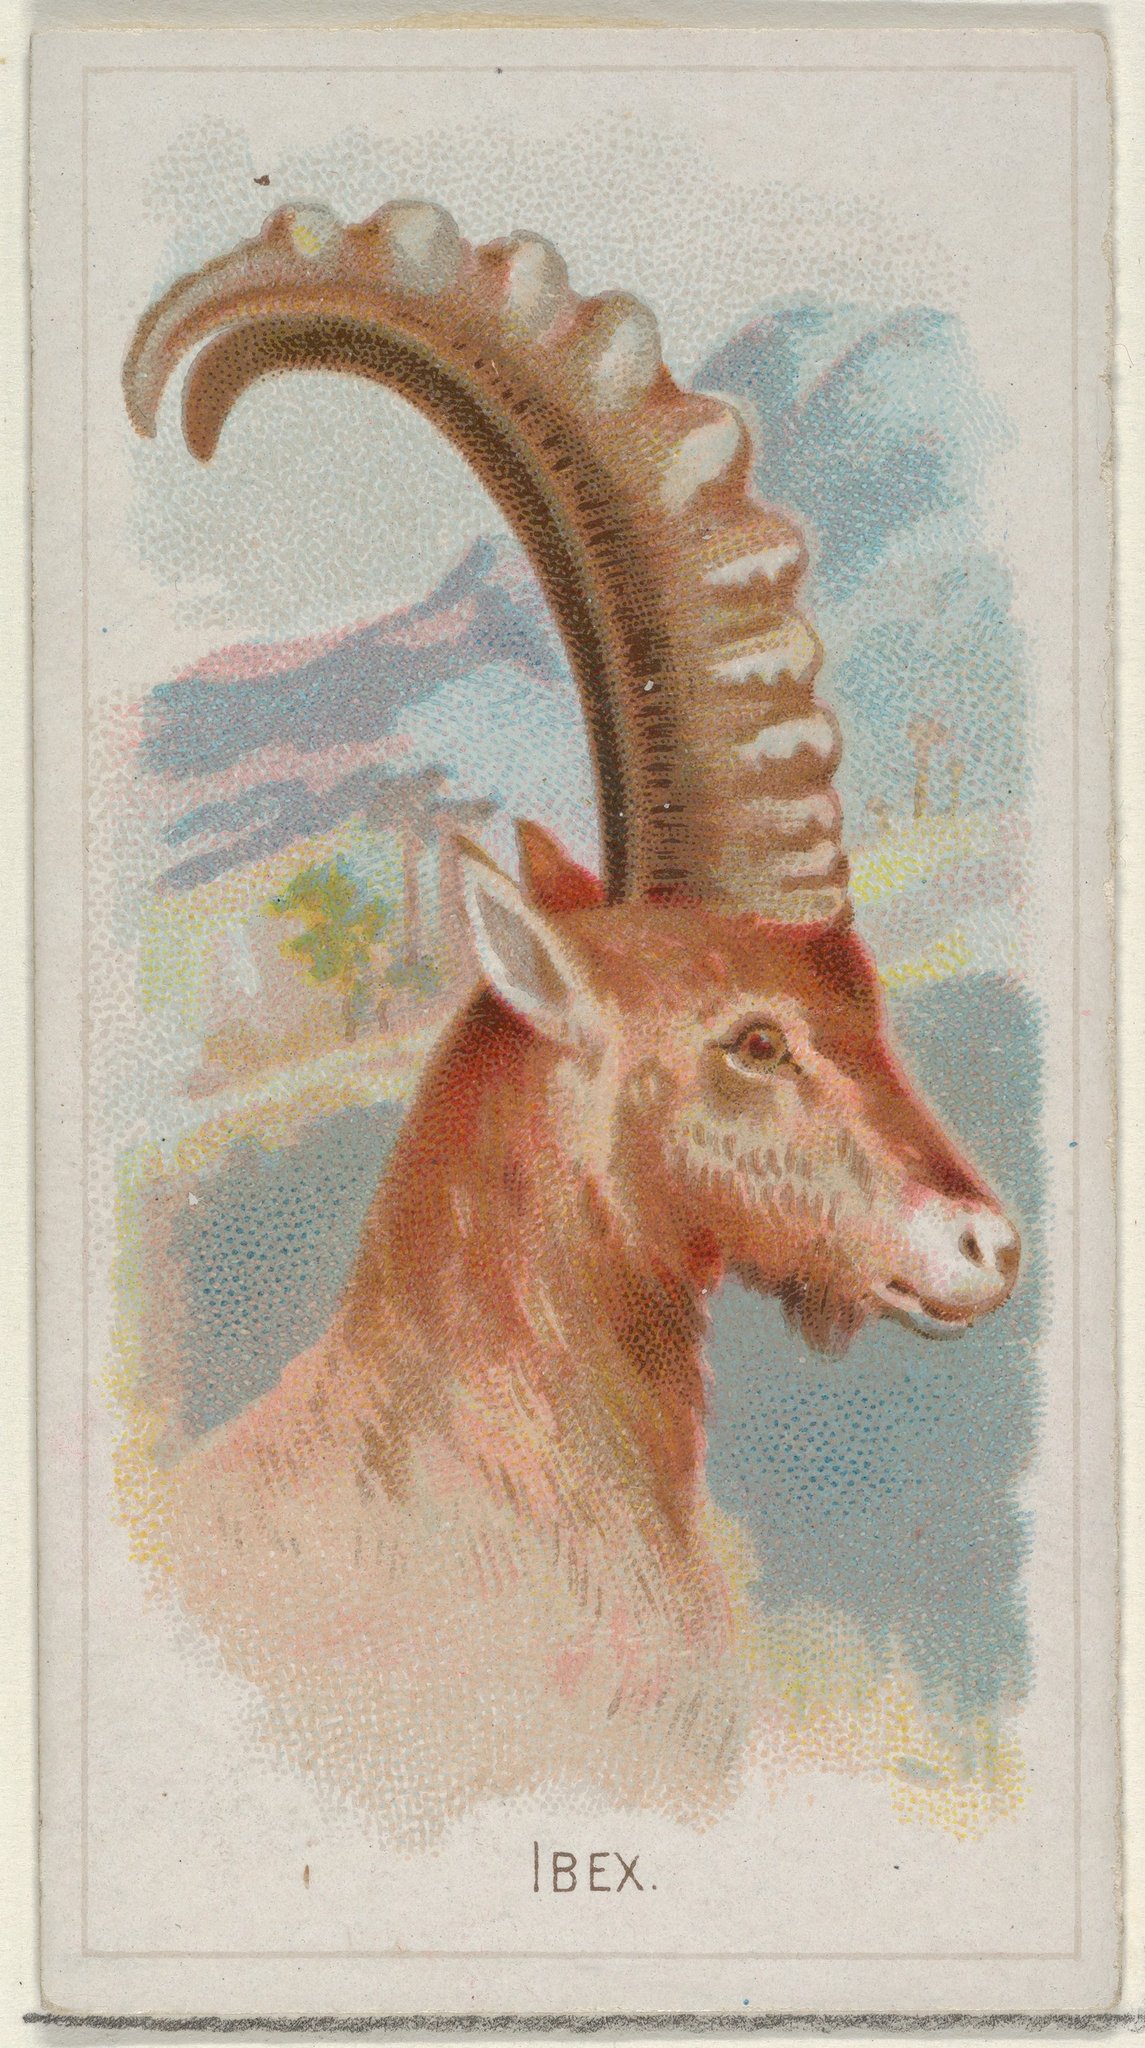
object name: print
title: Ibex, from the Wild Animals of the World series (N25) for Allen & Ginter Cigarettes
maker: allen & ginter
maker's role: publisher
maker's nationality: american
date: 1888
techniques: color lithograph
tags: ibex